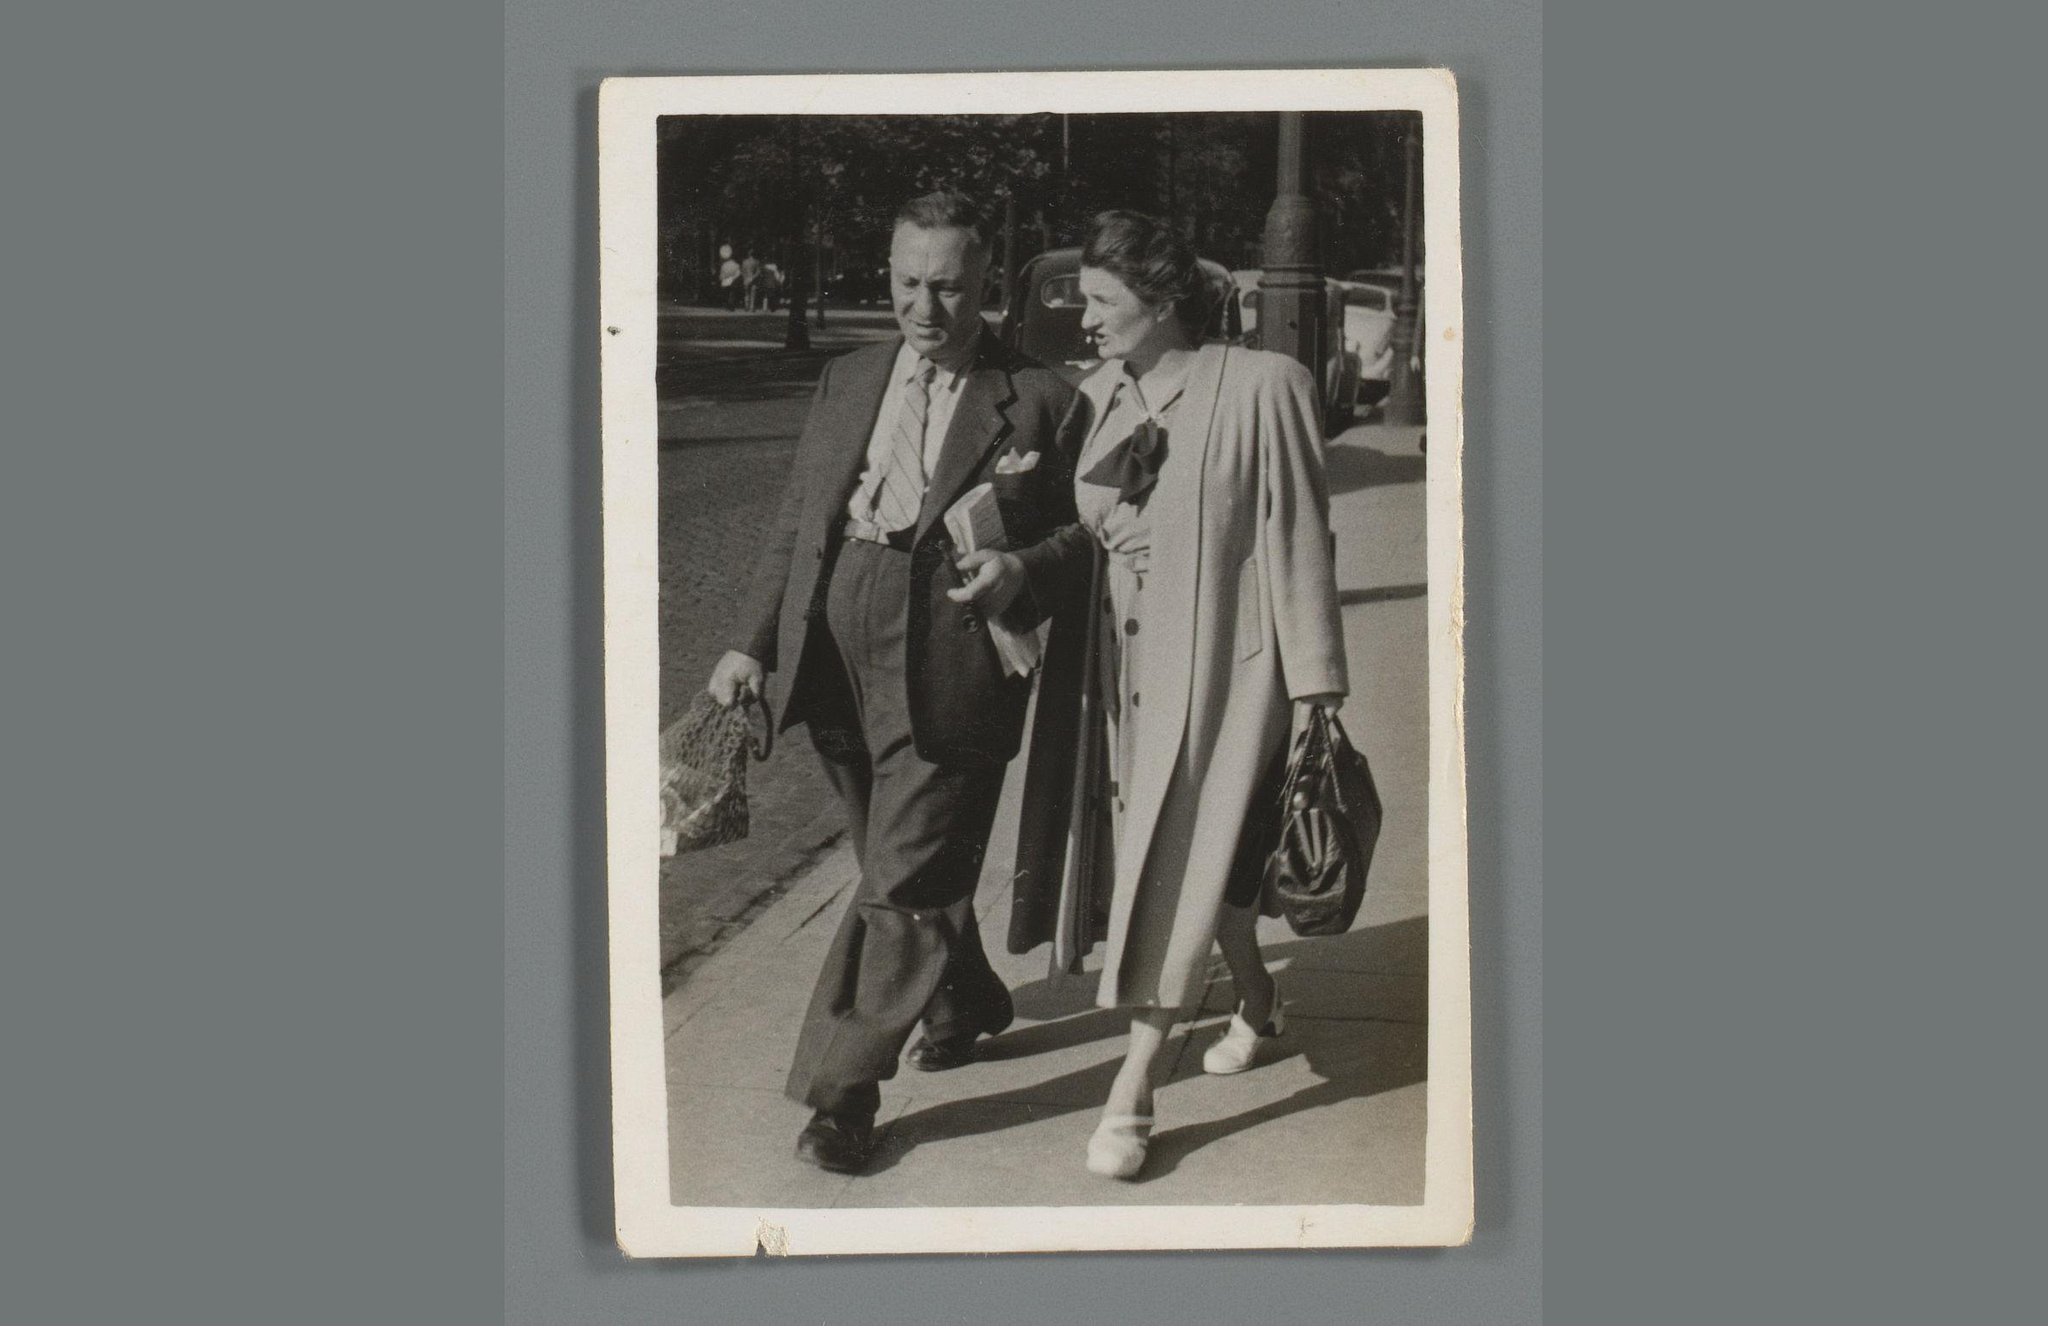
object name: photograph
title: Portret van een onbekende man en vrouw lopend op straat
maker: Anonymous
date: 1907-1949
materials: paper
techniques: gelatin silver print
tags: strolling, historical persons not known by name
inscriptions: date: ‘Juli 1949’